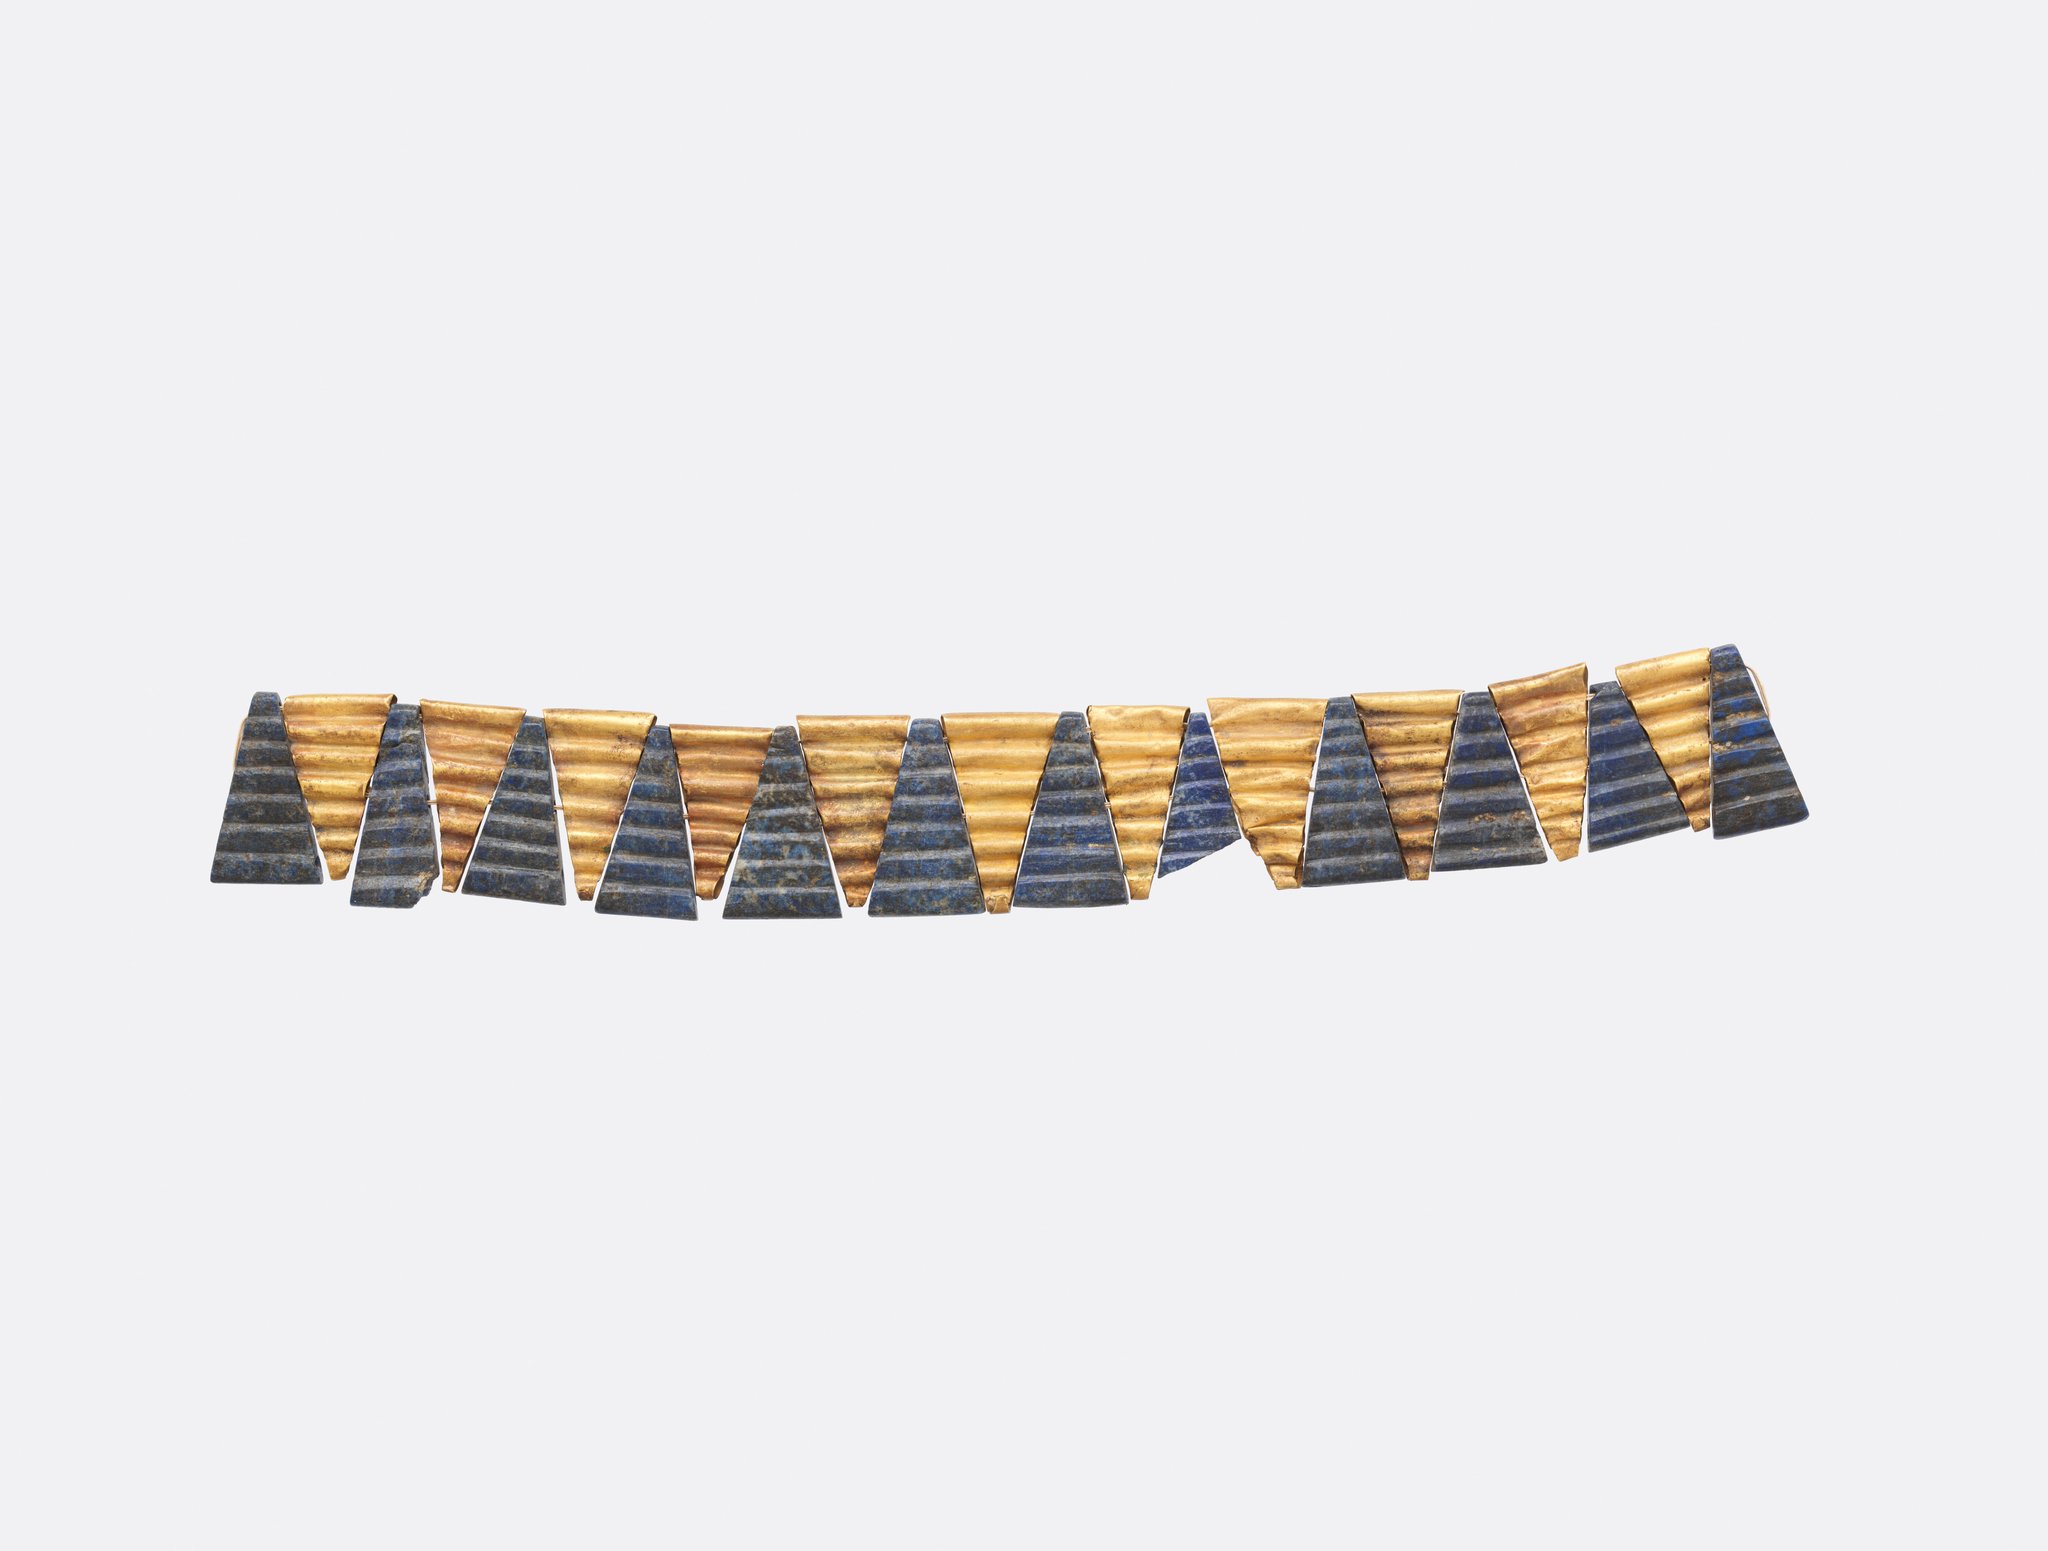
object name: necklace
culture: sumerian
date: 2600-2500 BCE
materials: gold, lapis lazuli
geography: mesopotamia